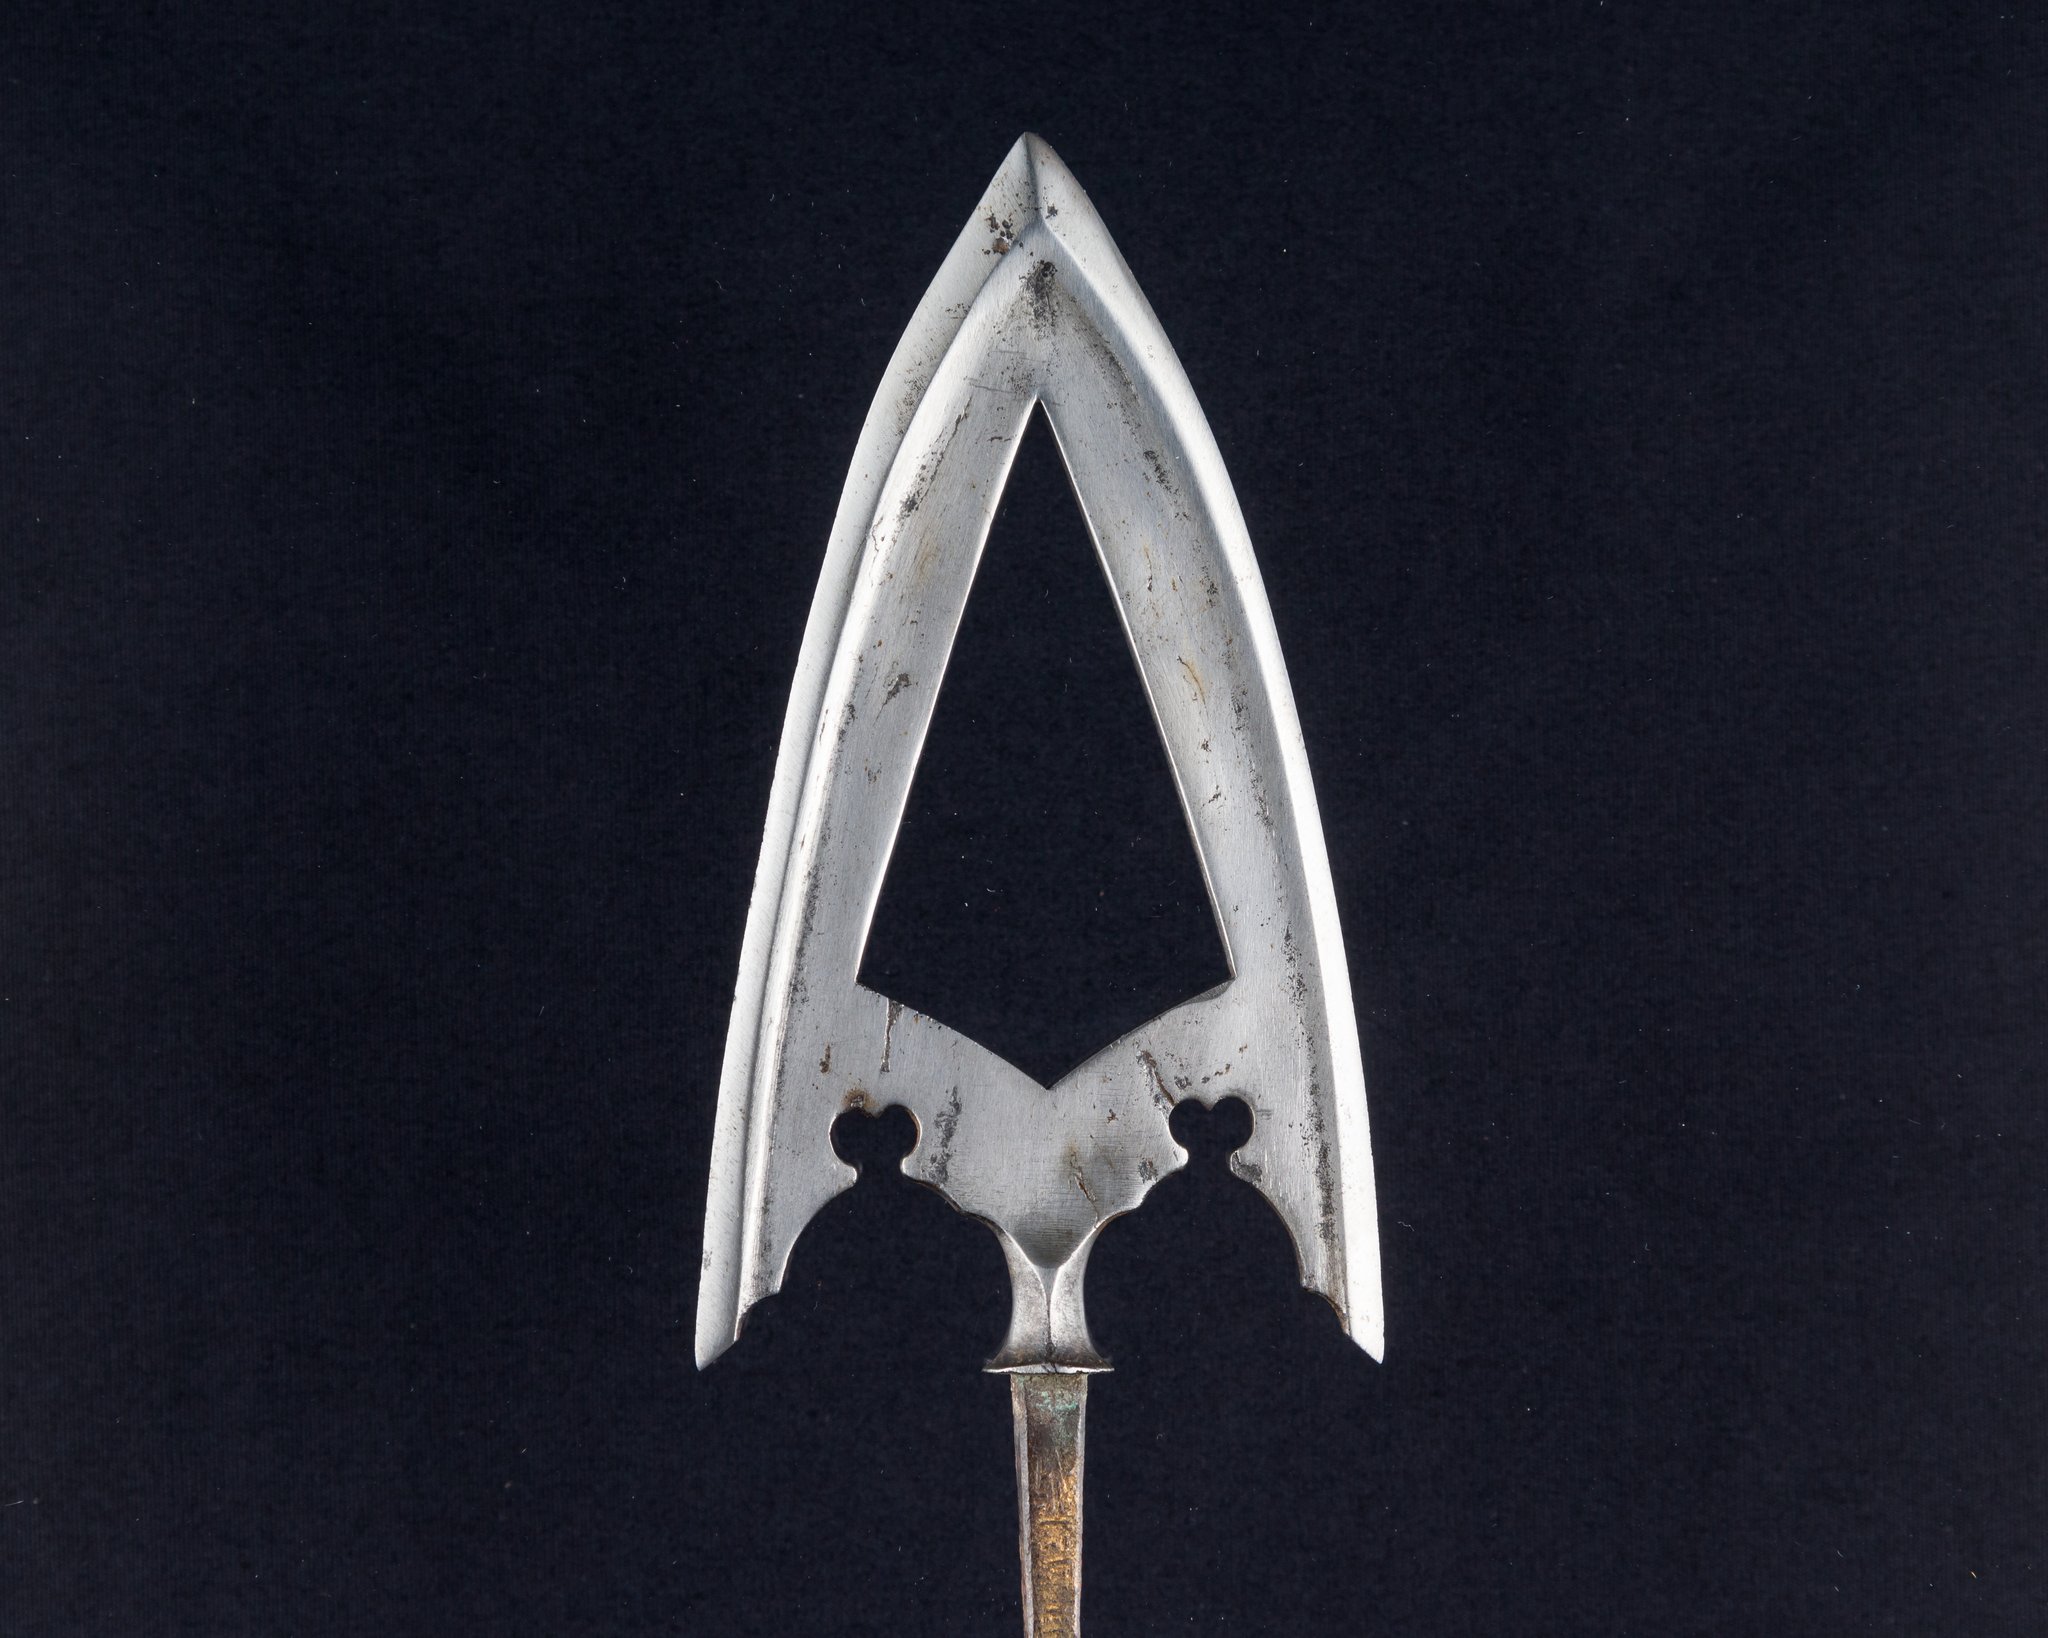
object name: arrowhead i yanone i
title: Arrowhead (Yanone)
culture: japanese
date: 1701-1800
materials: steel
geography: japan